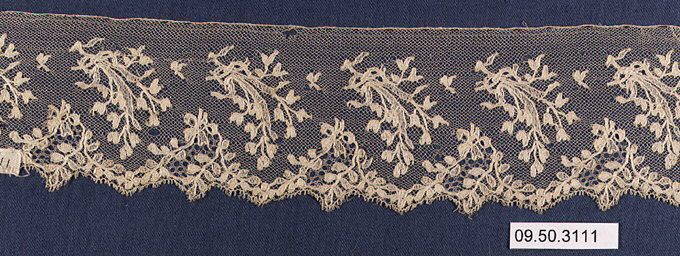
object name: strip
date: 1801-1900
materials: lace